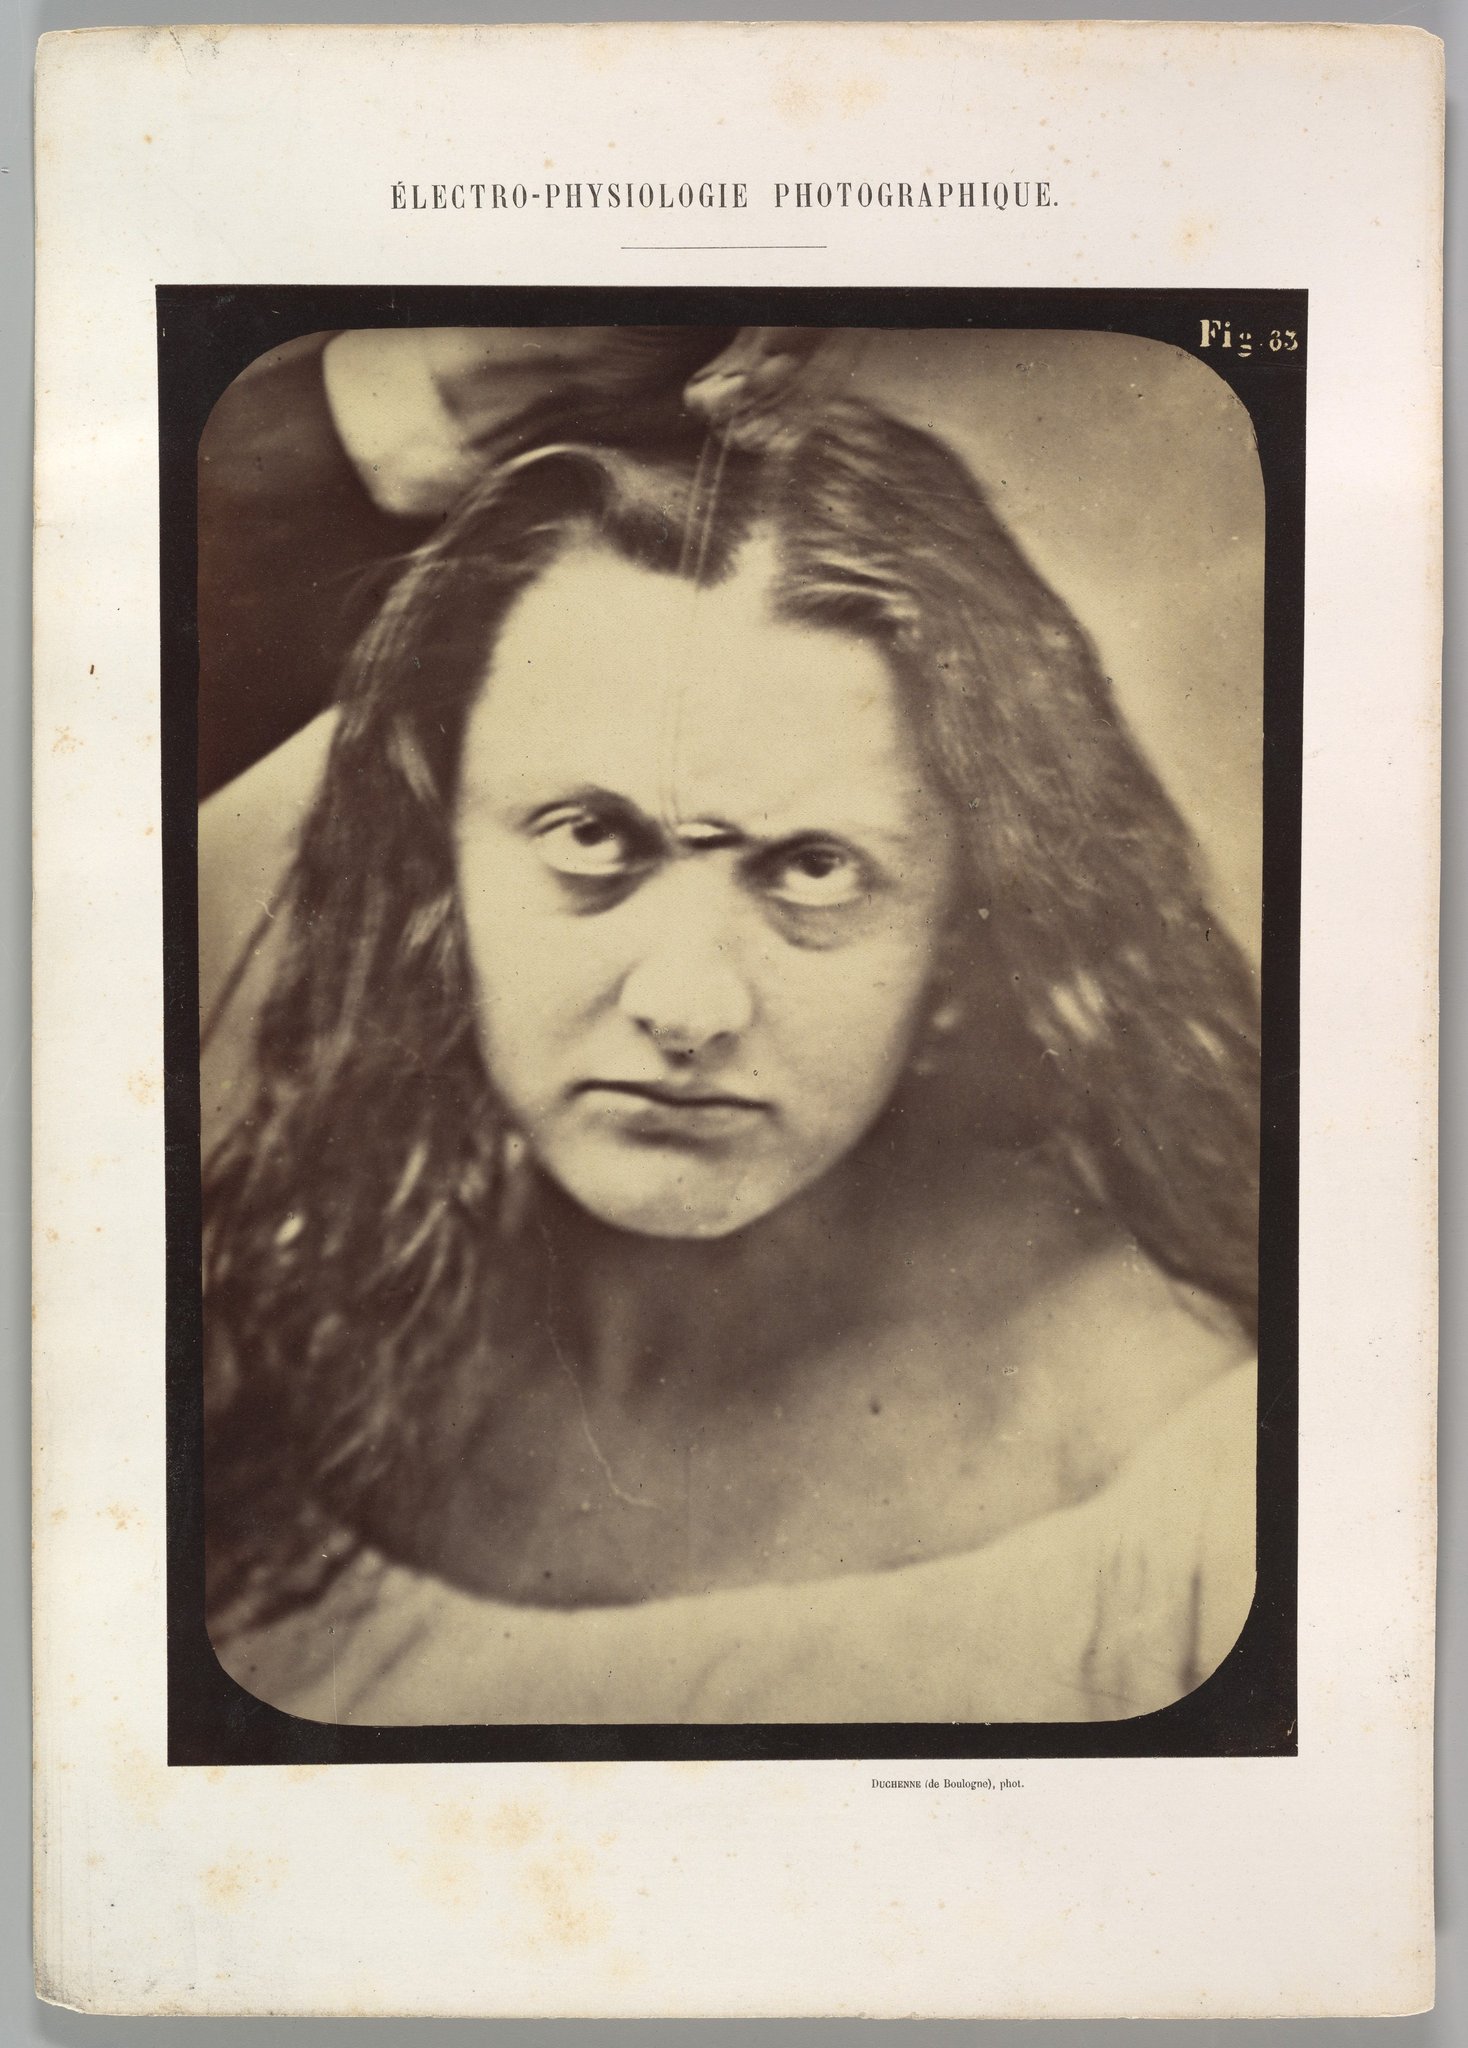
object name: photograph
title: Figure 83: Lady Macbeth, ferocious cruelty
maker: guillaume-benjamin-amand duchenne de boulogne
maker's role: artist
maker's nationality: french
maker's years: 1806-1875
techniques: albumen silver print, glass negative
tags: science,portraits,women